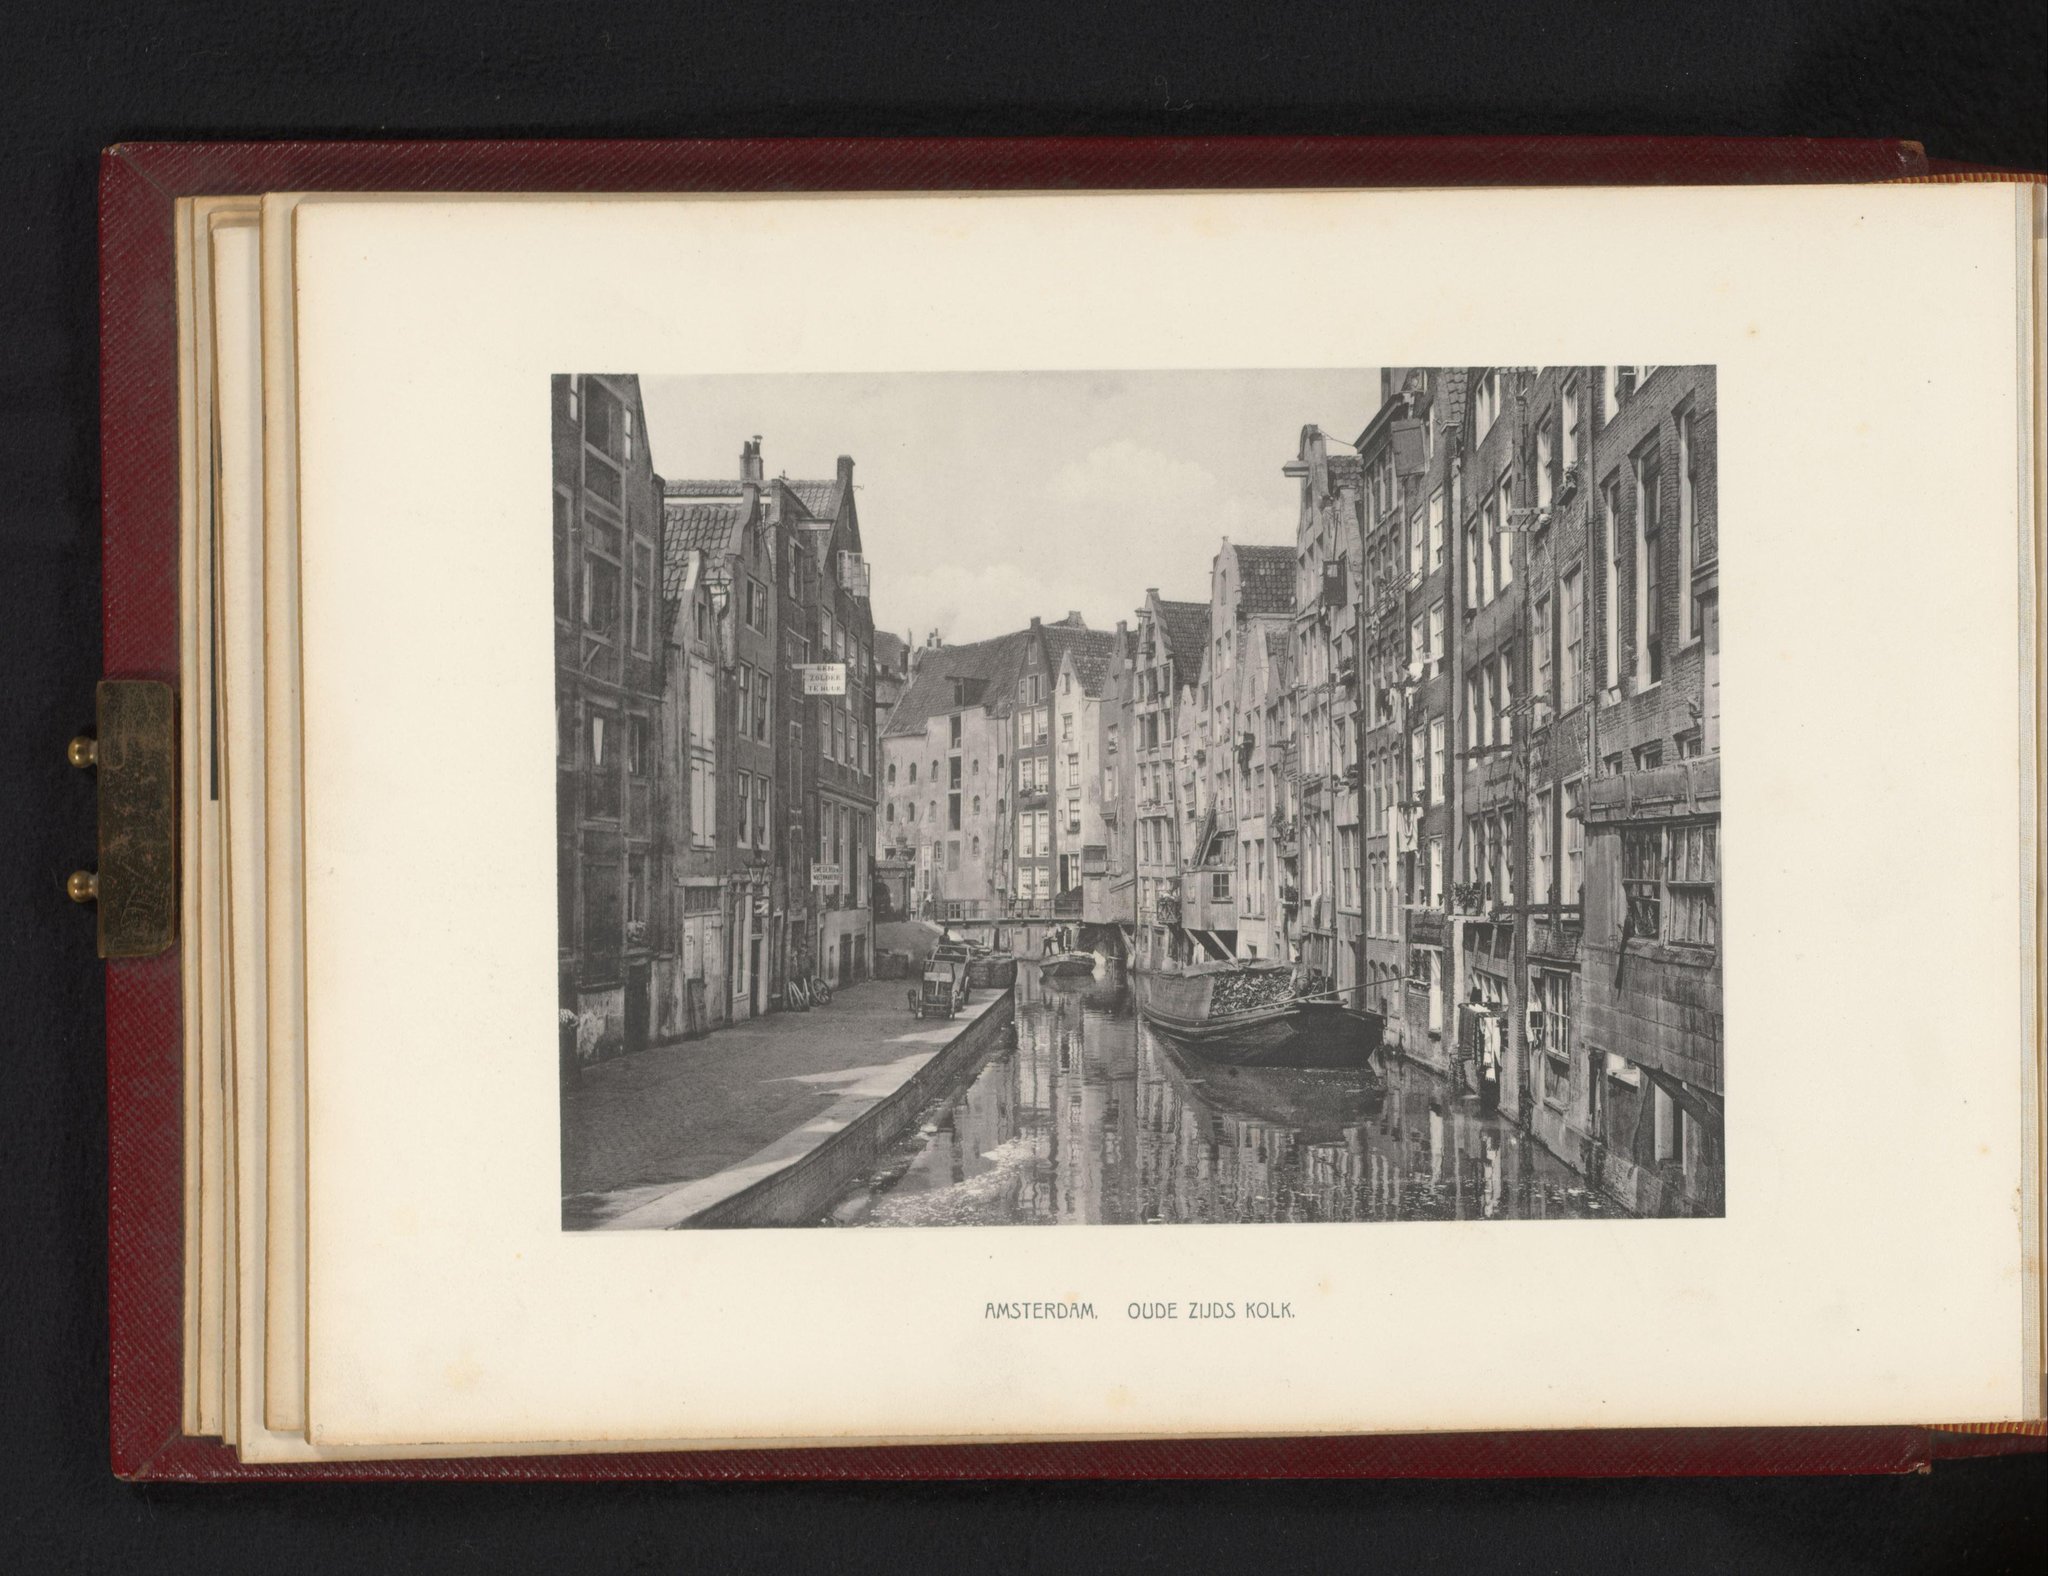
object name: photomechanical print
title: Amsterdam Oude Zijds Kolk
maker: Anonymous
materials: paper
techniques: photograph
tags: ships (in general), canals, waters (in city), civic architecture; edifices; dwellings, amsterdam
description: Deze pagina maakt deel uit van een album.